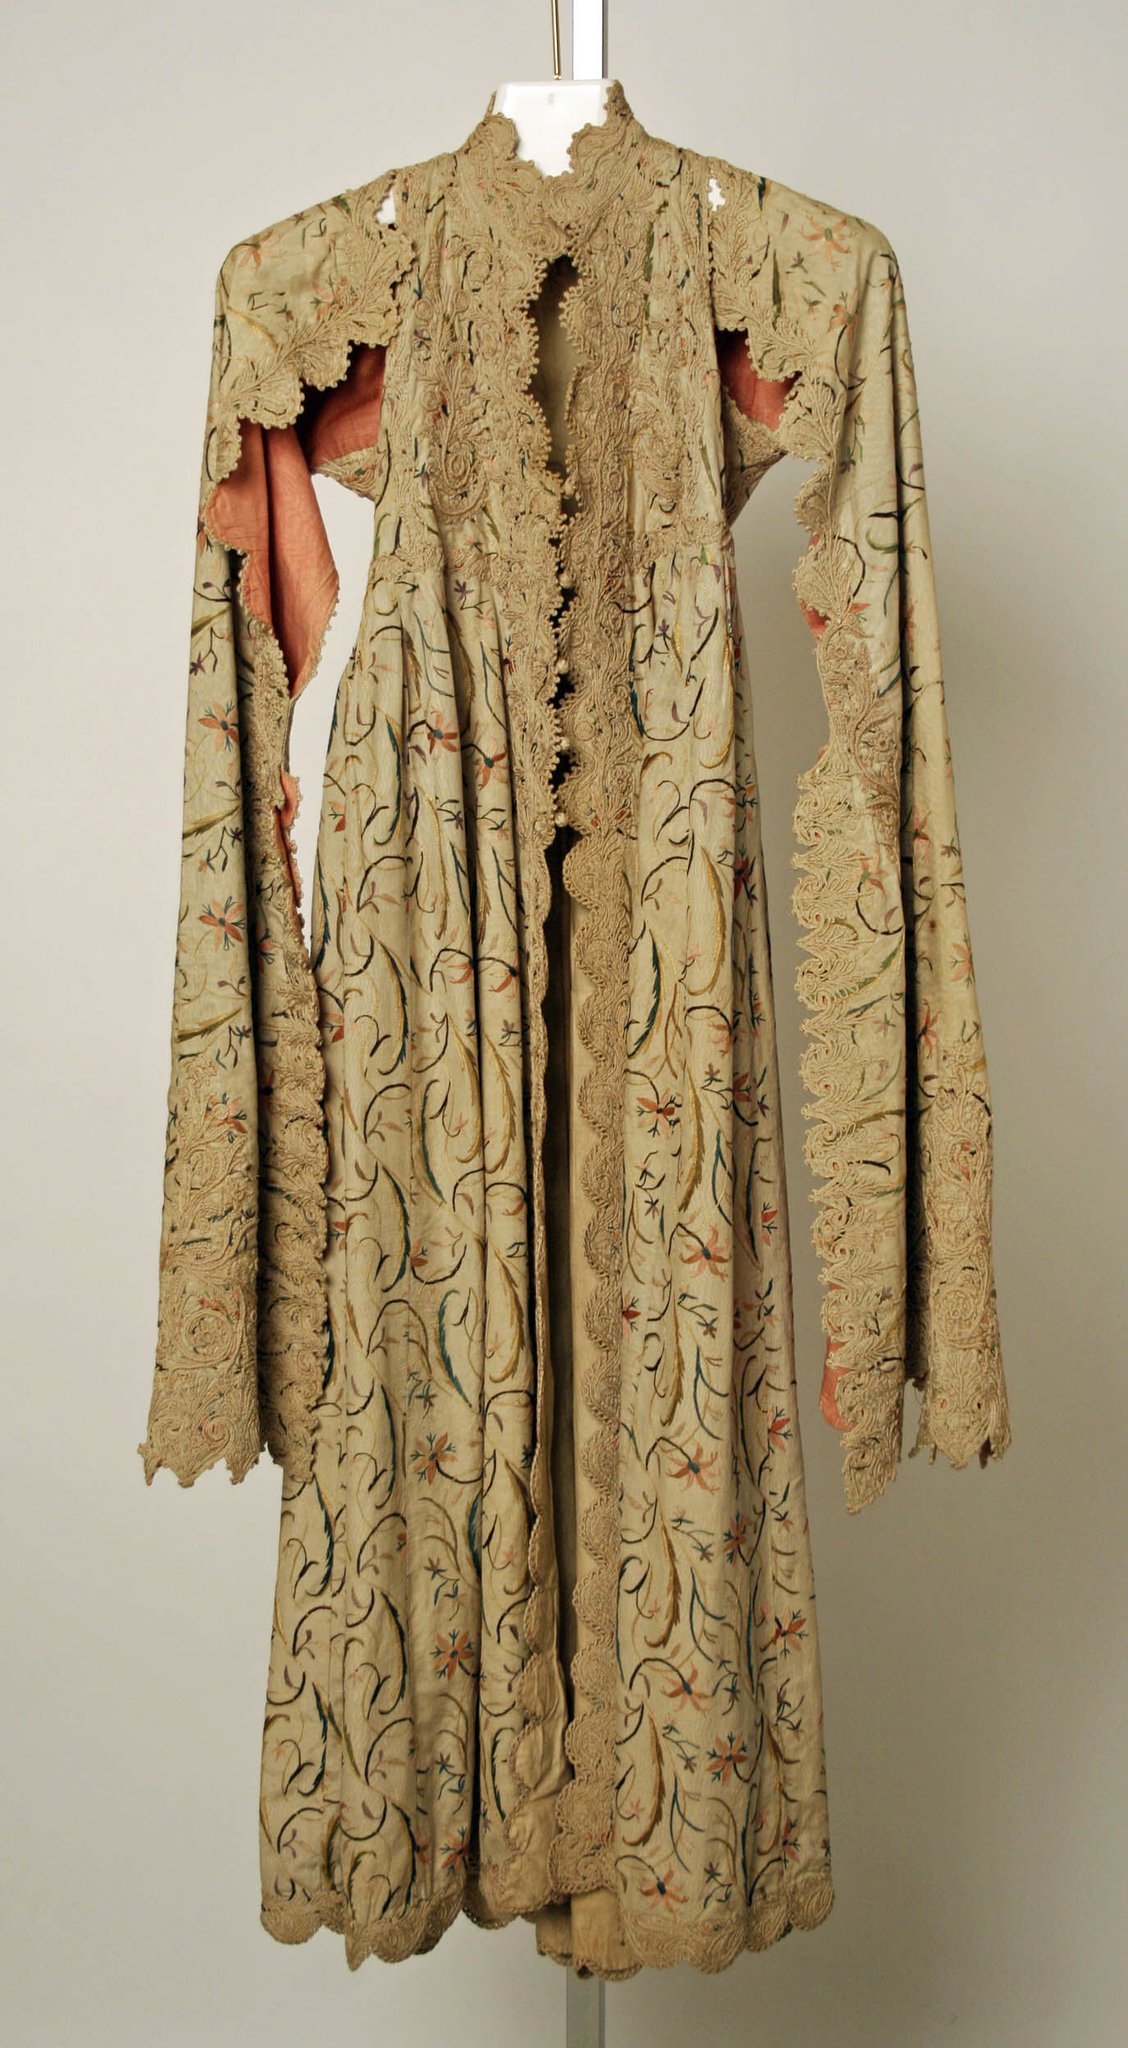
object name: robe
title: Child's Robe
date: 1834-1933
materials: silk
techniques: embroidery, lining, satin weave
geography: balkans